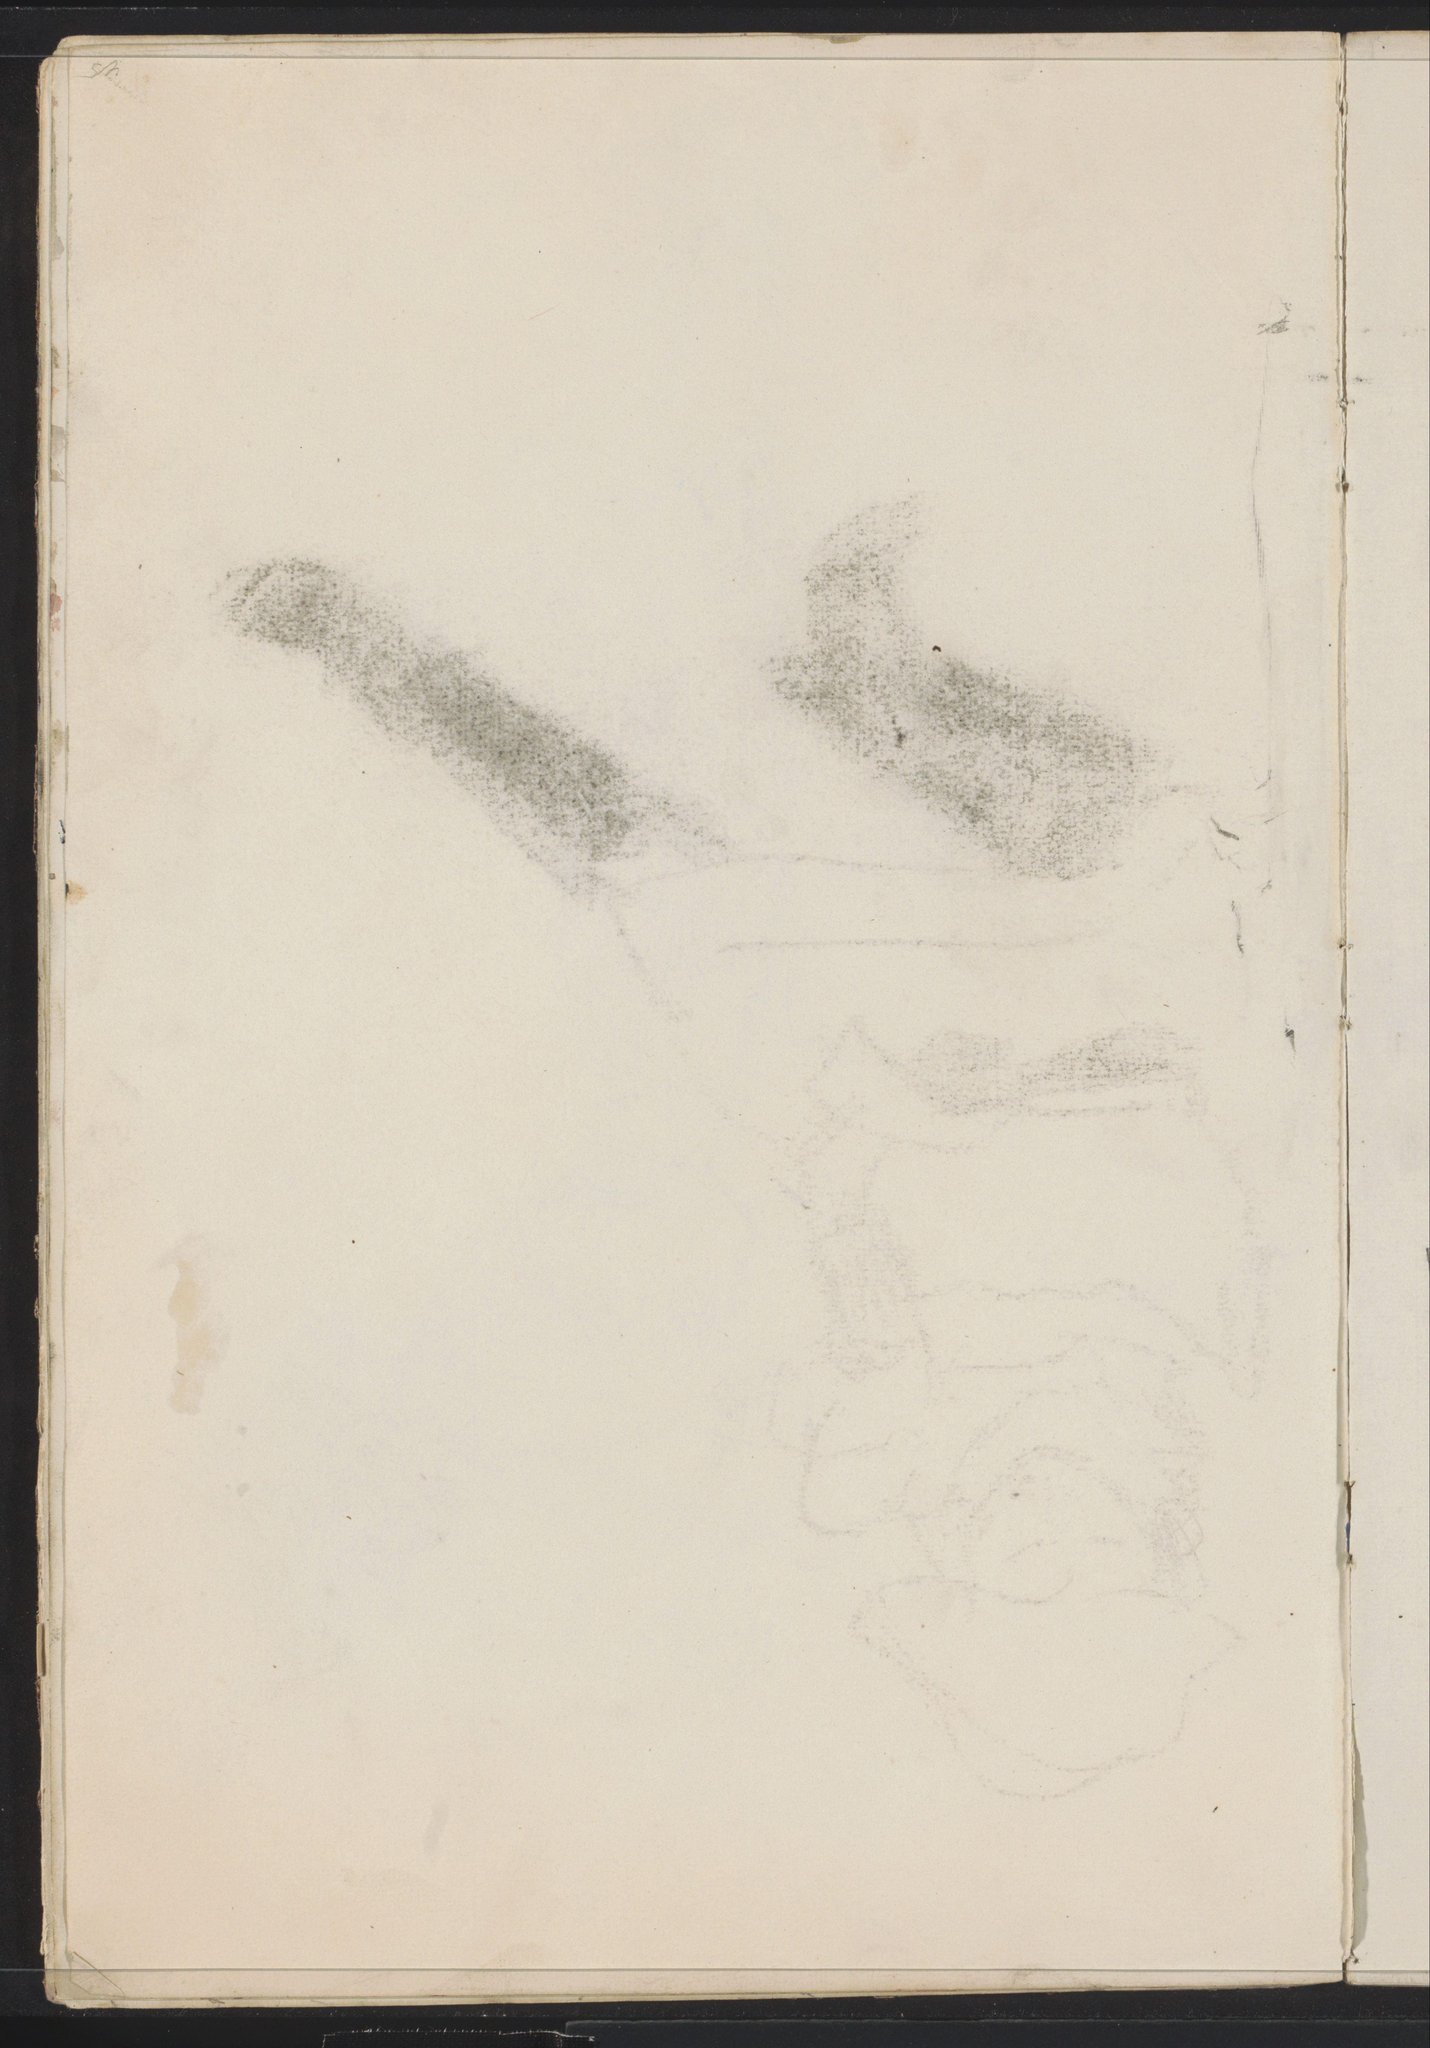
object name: sketchbook leaf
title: Abklatsch van de krijttekening op blad 7 recto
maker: isaac israels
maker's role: draughtsman, painter, print maker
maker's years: 1865-1934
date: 1875-1934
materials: paper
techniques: printmaking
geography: the hague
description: Blad 6 verso uit schetsboek LXIX met 25 bladen.